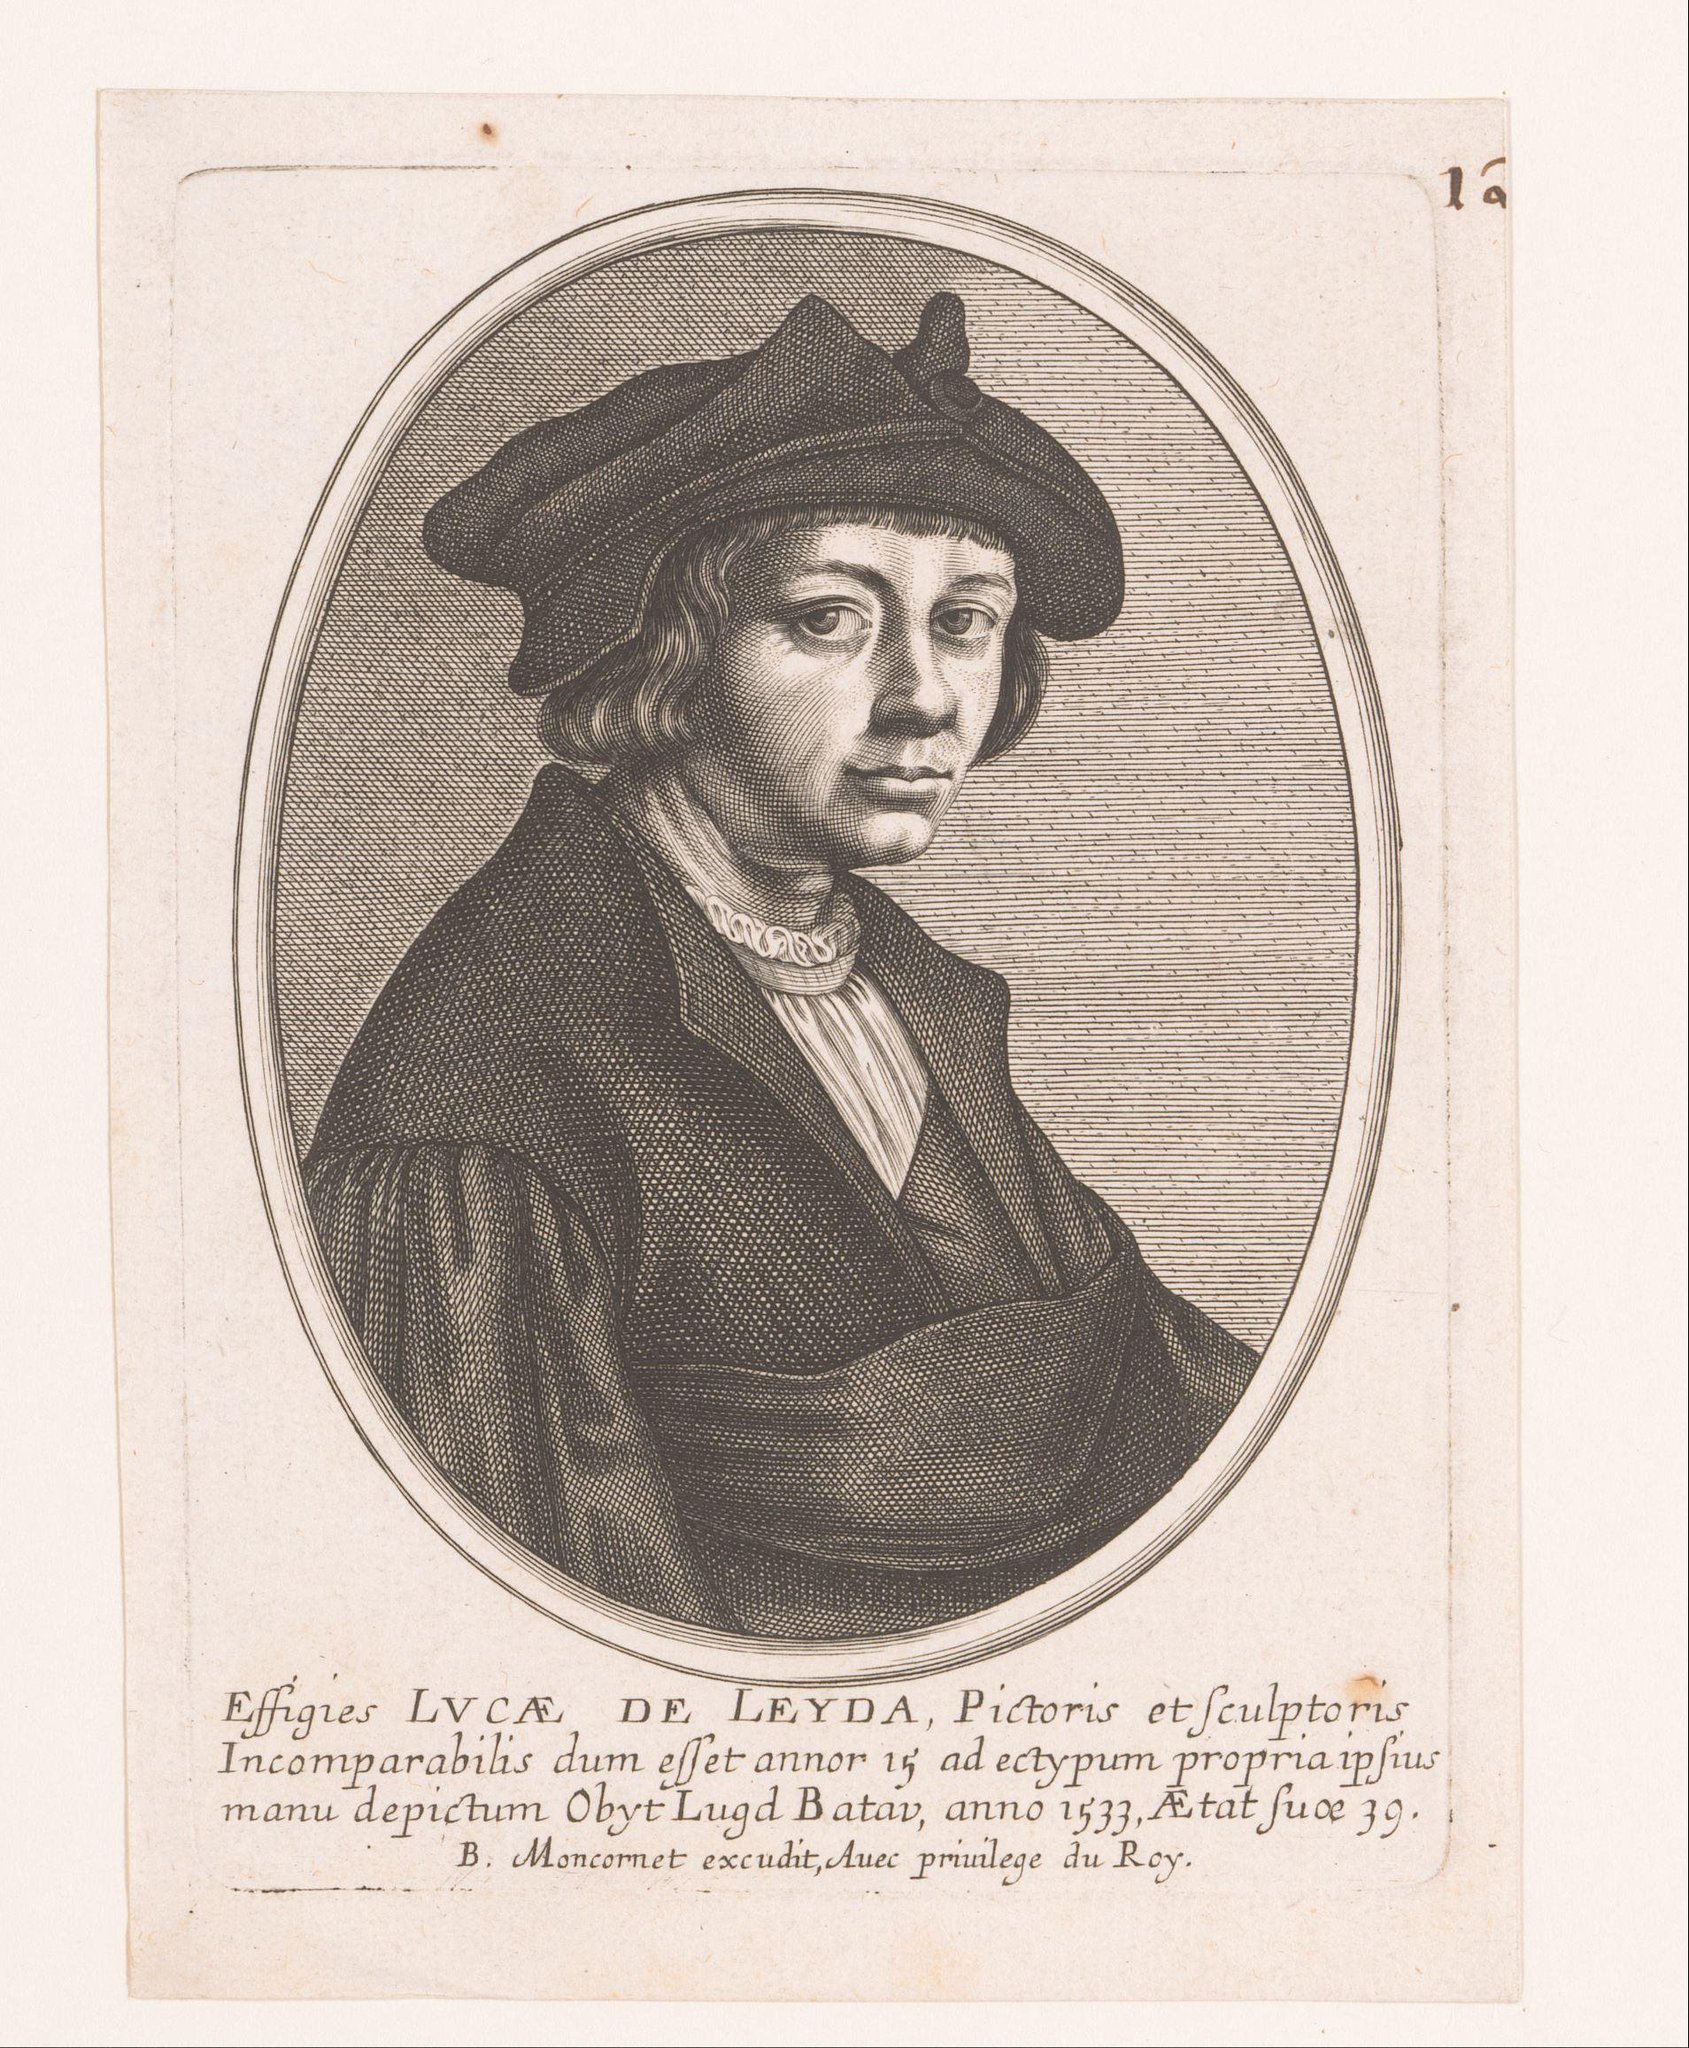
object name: print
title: Portret van Lucas van Leyden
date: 1610-1668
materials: paper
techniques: engraving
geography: paris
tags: painter, draughtsman, lucas van leyden, historical persons, portrait, self-portrait of painter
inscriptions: collector's mark: Lugt 2228